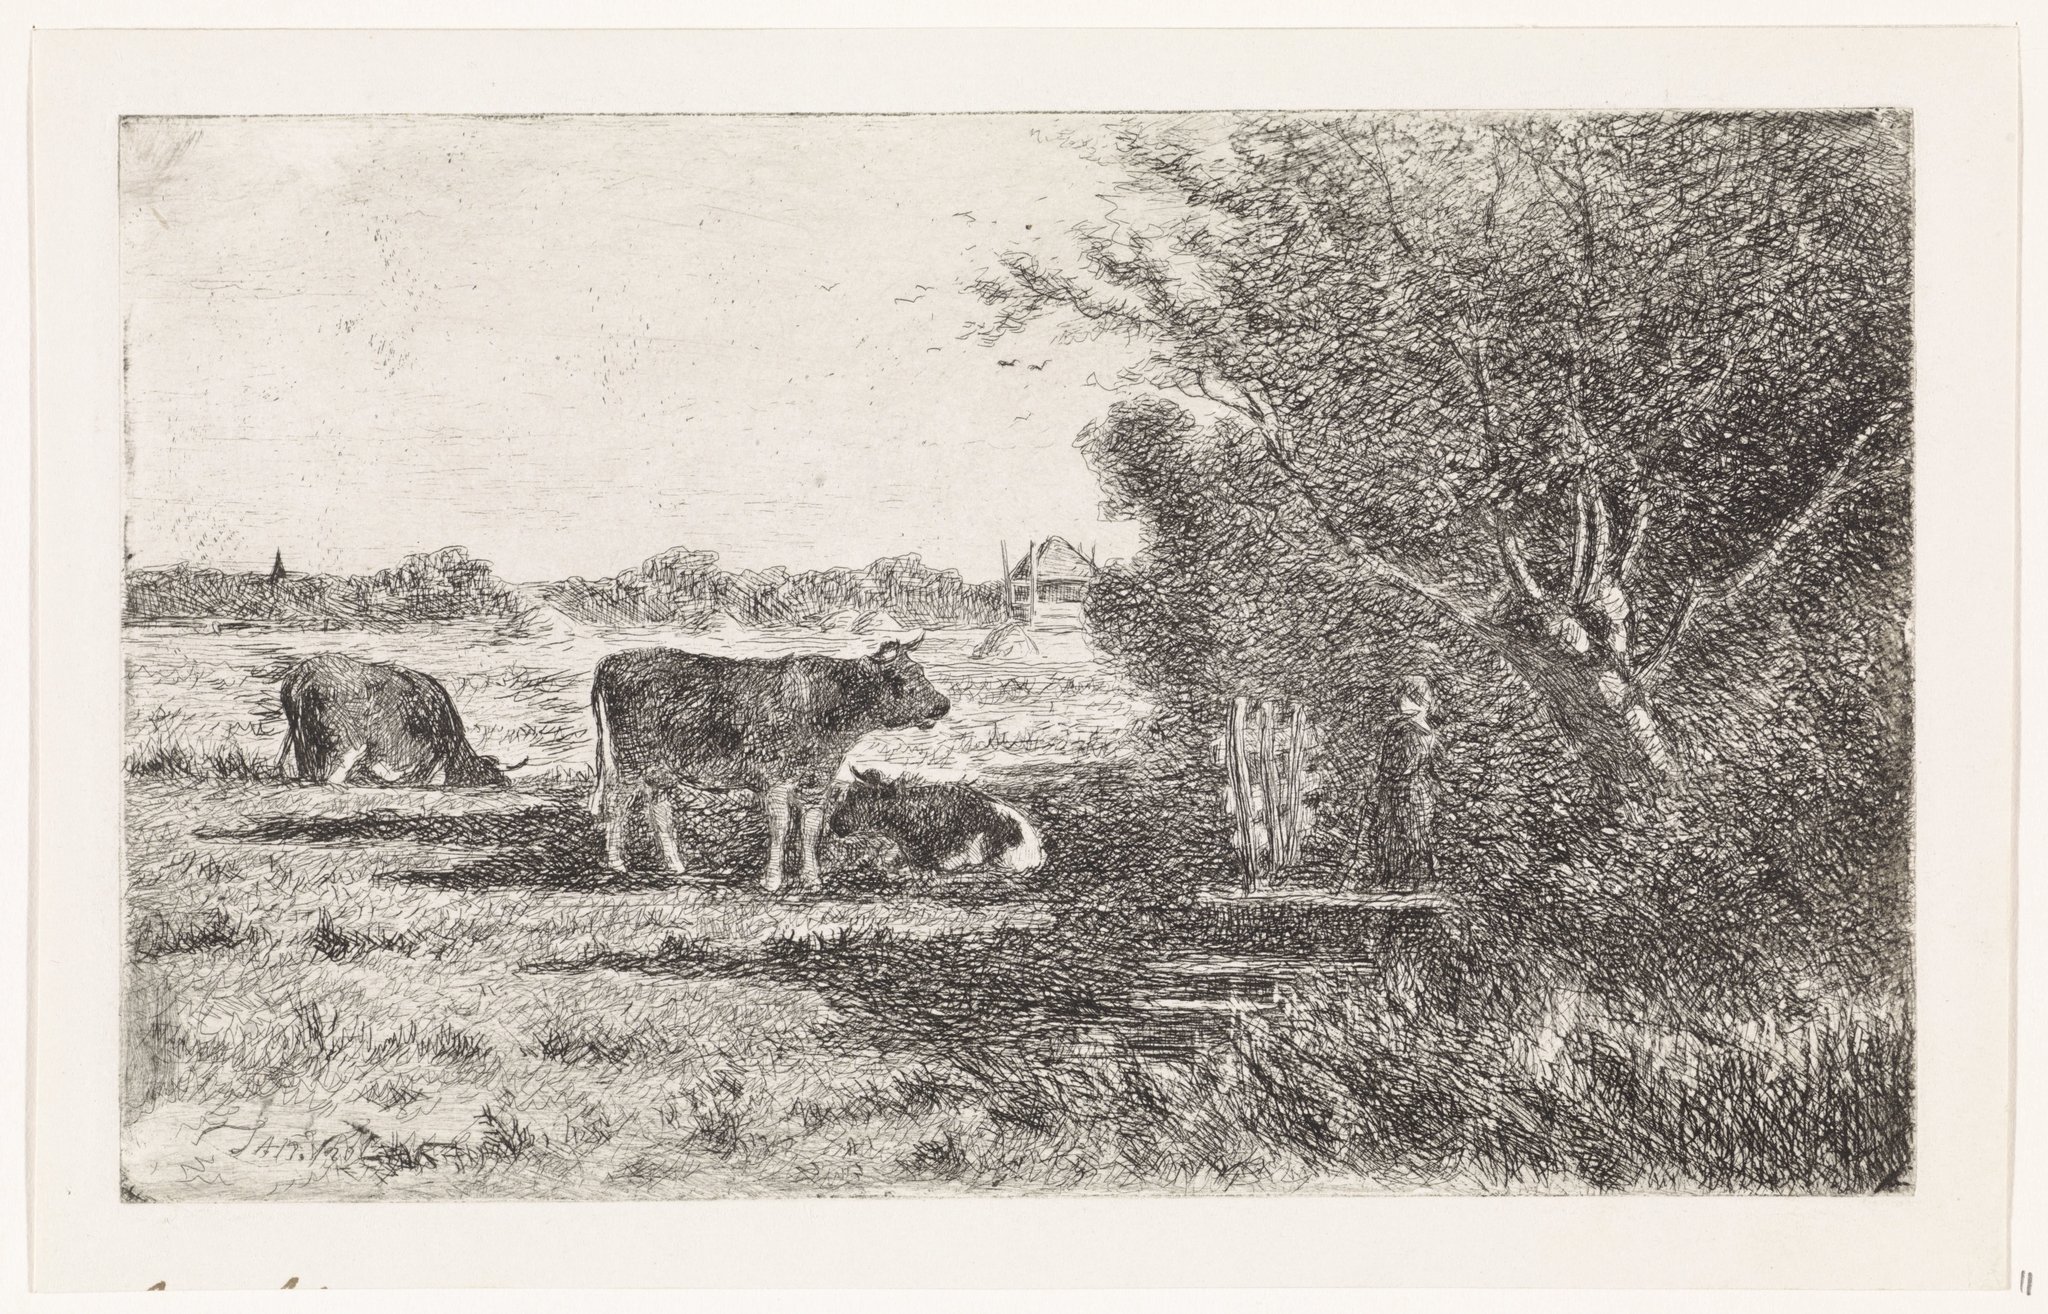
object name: print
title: Koeien in weiland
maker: jan vrolijk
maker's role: draughtsman, painter, print maker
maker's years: 1846-1894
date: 1860-1885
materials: paper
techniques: etching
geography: the hague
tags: cow, hay-stack, trees: willow, pond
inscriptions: collector's mark: Lugt 2228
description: Koeien staan in een weiland bij een vijver. Een kind bij het hek kijkt naar hen. Op de achtergrond een hooischuur.